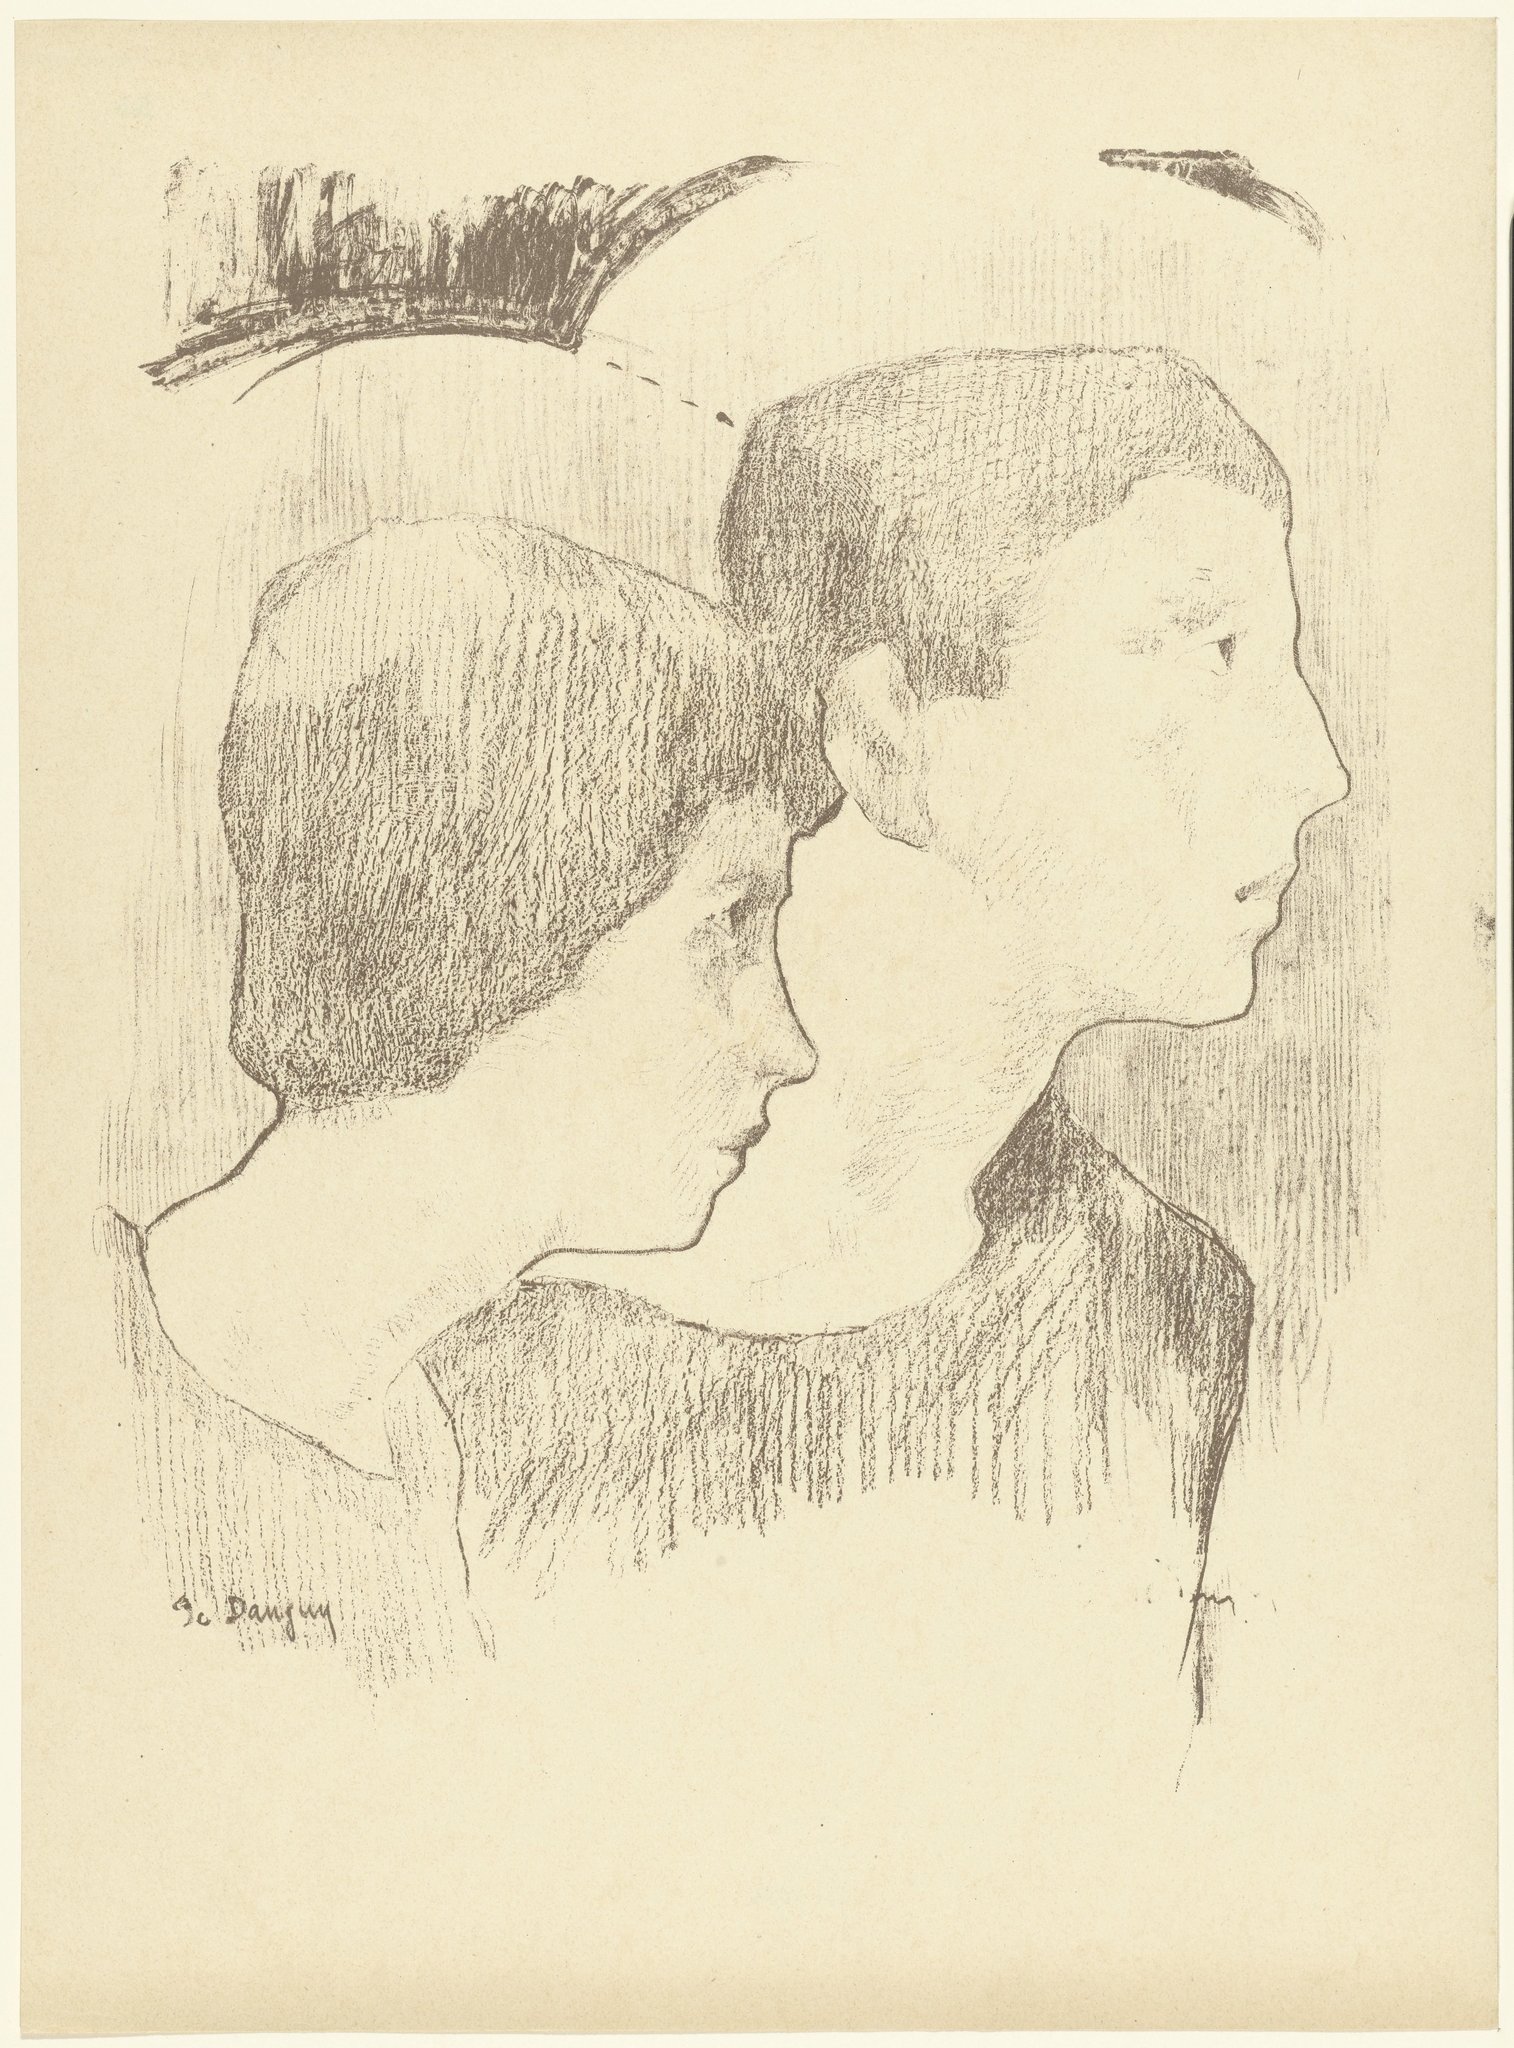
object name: print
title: L'Epreuve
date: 1804-1895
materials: paper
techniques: printing, lithograph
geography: paris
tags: youth, adolescent, martyr(s) (often with palm-branches)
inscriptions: collector's mark: Lugt 2760, collector's mark: Lugt 2228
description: Verschenen in album met tien originele prenten als supplement bij tijdschrift: L'Epreuve, april 1895, prent nr. 5